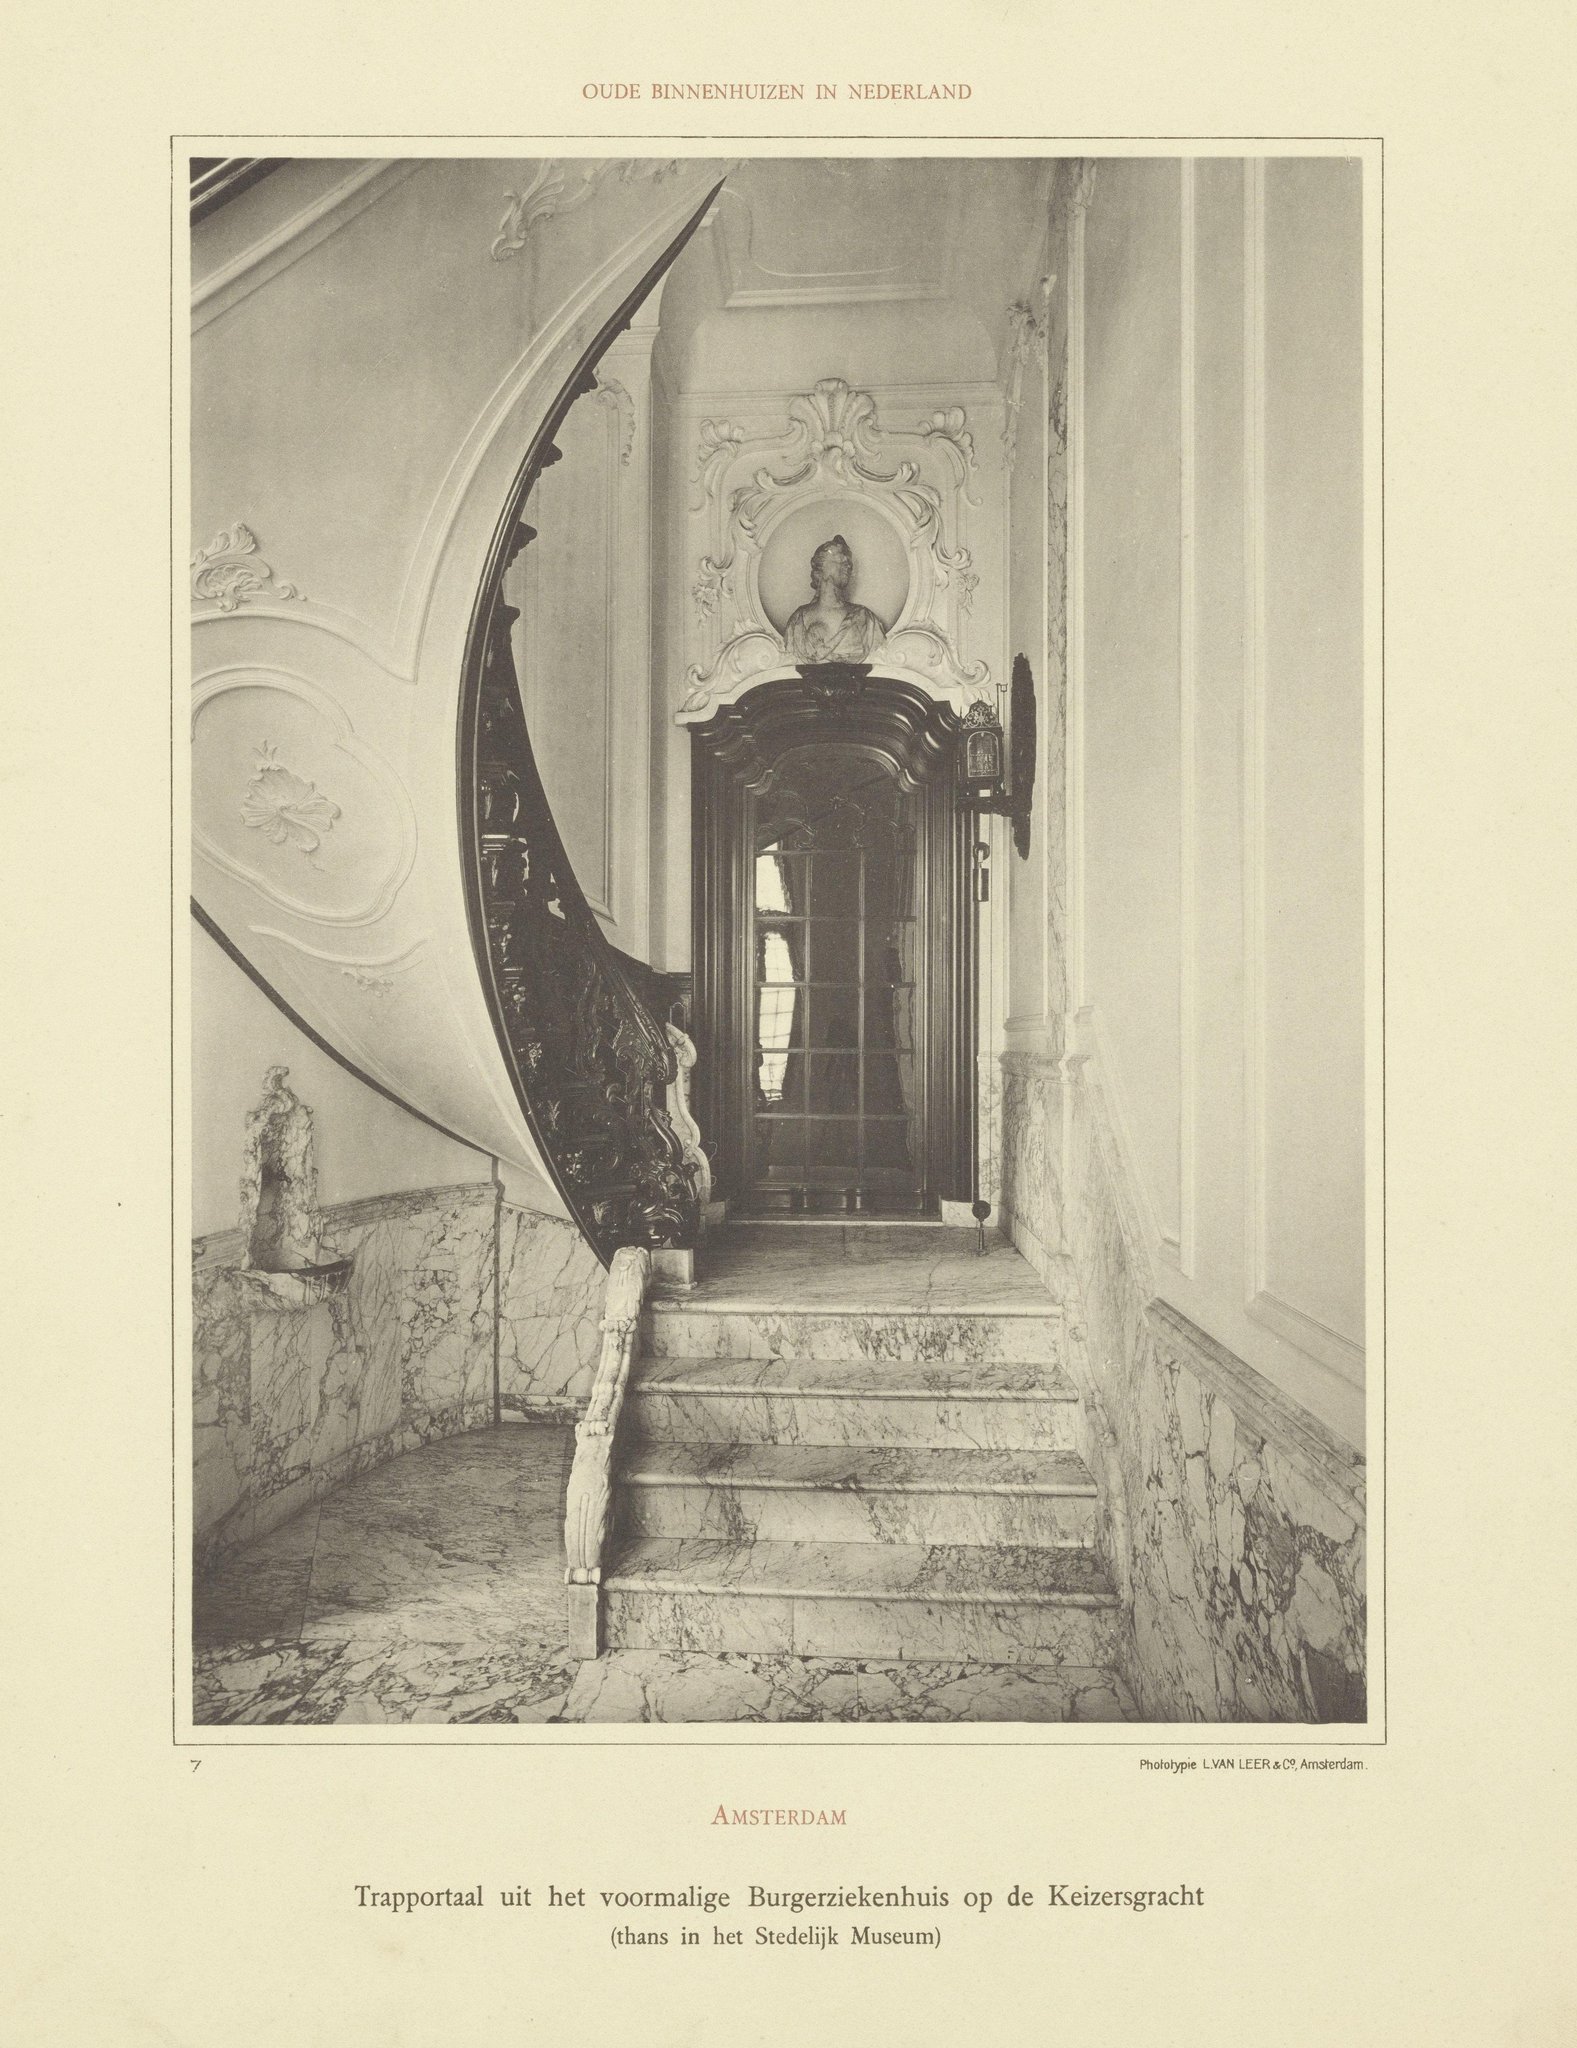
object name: spiral stair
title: Onderdelen van het trapportaal uit het pand aan de Keizersgracht 187 te Amsterdam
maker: Anonymous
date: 1740-1760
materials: wood, marble